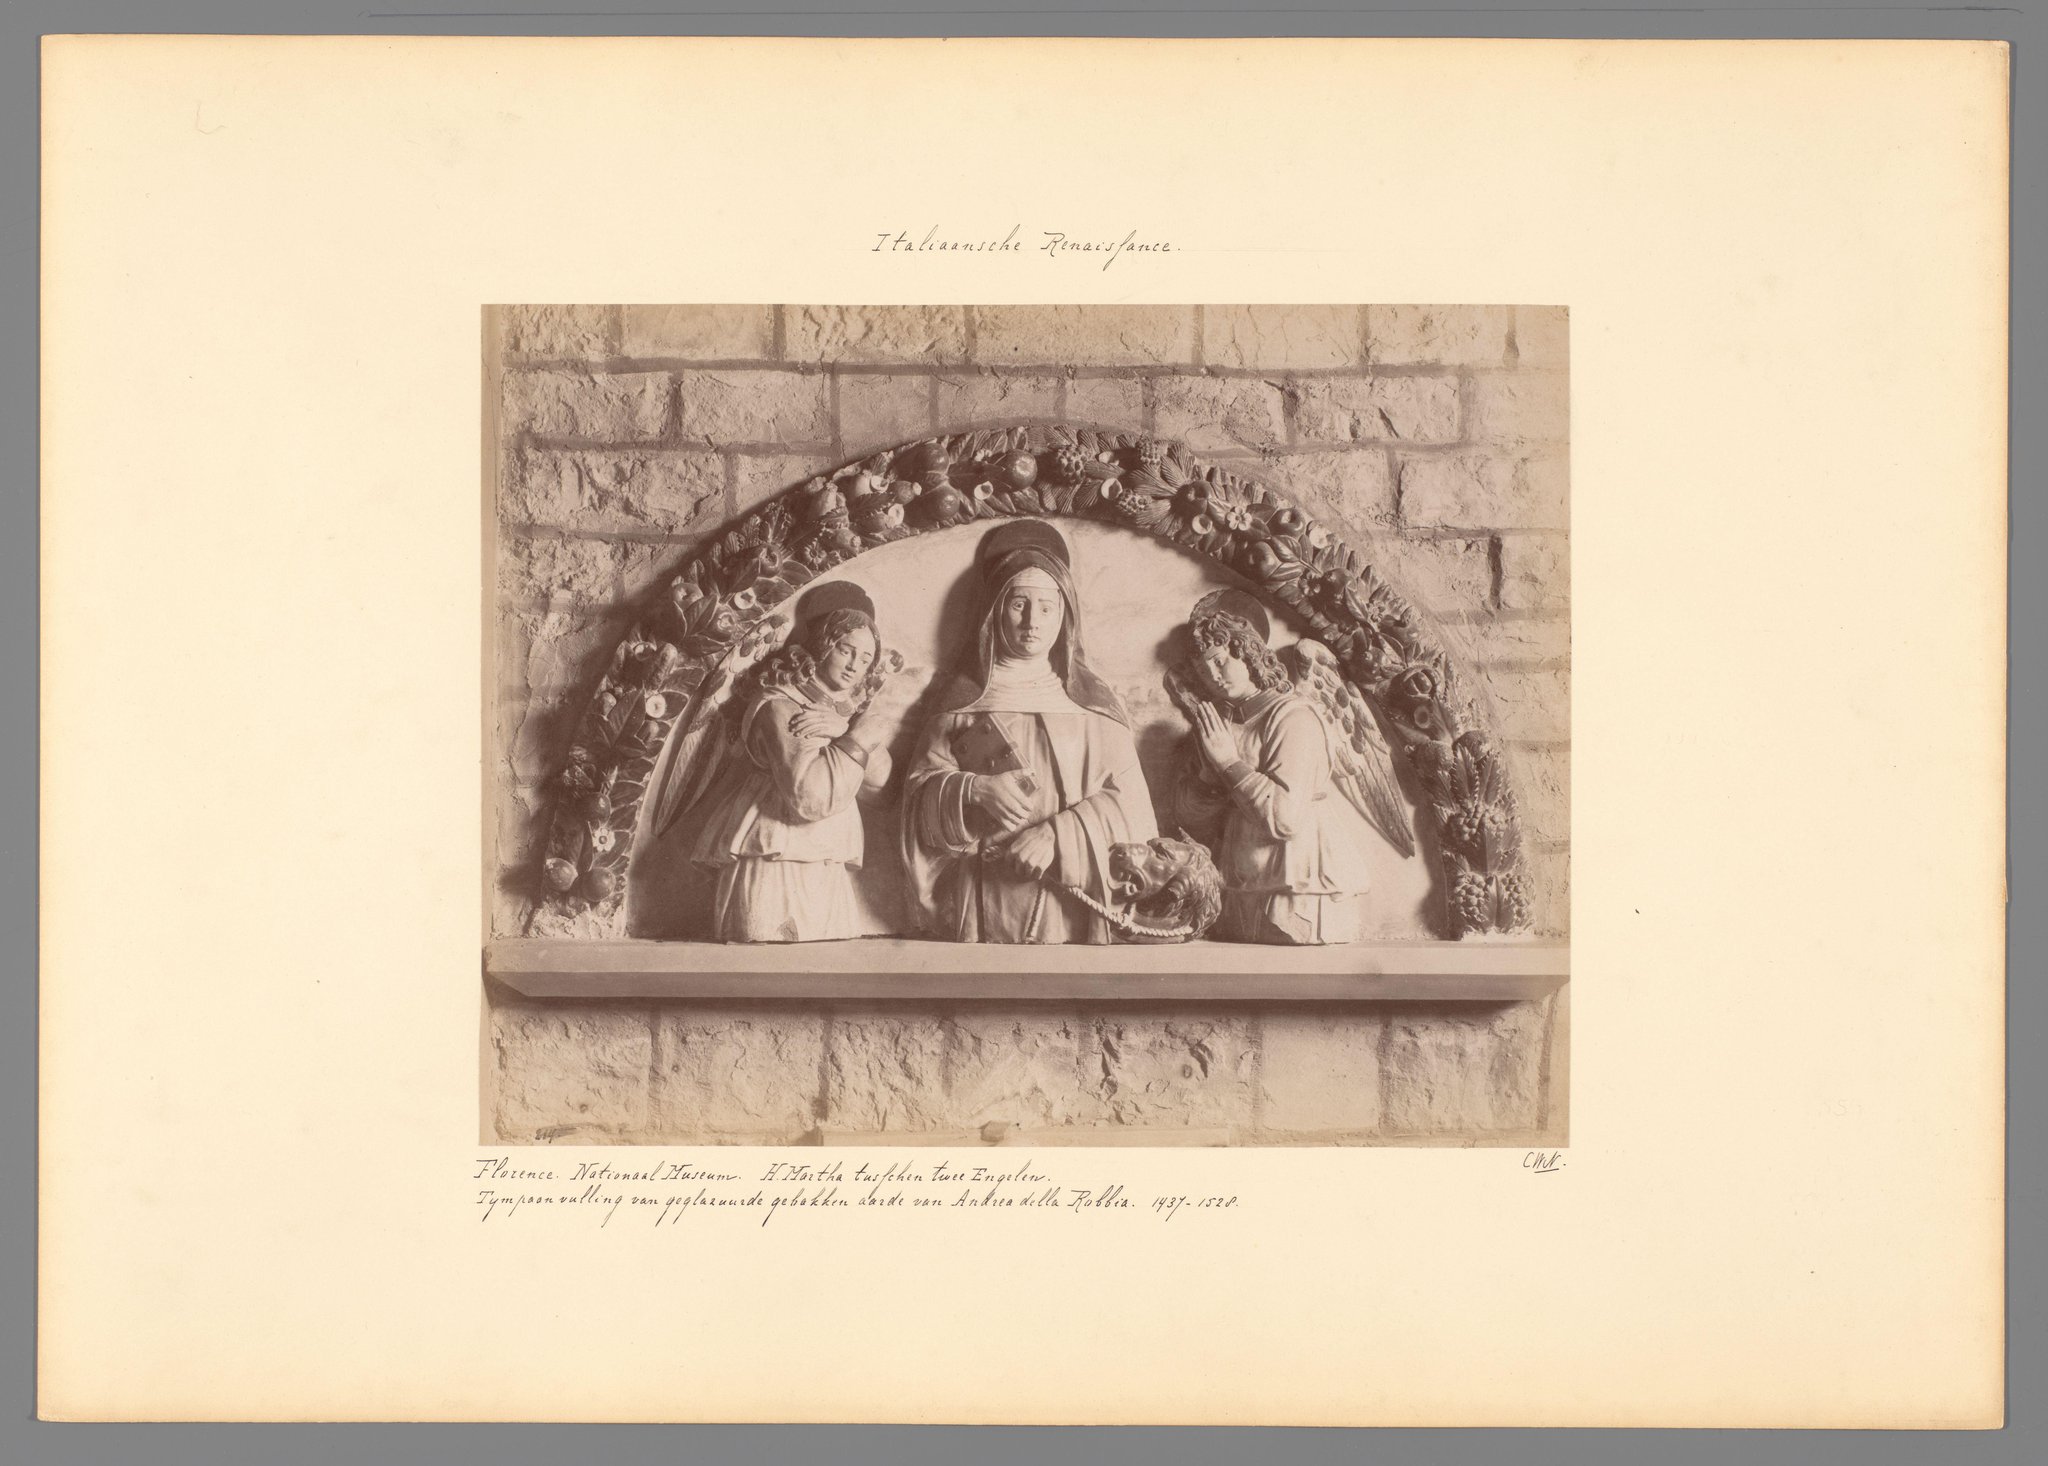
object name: photograph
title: Timpaanvulling voorstellend Marta tussen twee engelen door Andrea della Robbia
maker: Anonymous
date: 1875-1900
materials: cardboard, photographic support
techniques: albumen print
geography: europe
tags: the patroness of housewives, martha of bethany; possible attributes: aspergillum, broom, bunch of keys, dragon, ladle, angels, sculpture (+ relief ~ sculpture), europe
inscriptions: inscription: ‘CWN.’, collector's mark: ‘INSTITUUT VOOR KUNST-NIJVERHEIDSONDERWIJS GABRIËL METSUSTRAAT No. 16 AMSTERDAM’, inscription: ‘Italiaansche Renaissance.’, collector's mark: ‘KUNSTNIJVERHEIDSCHOOL QUELLINUS AMSTERDAM FRANS HALSSTRAAT 14.’